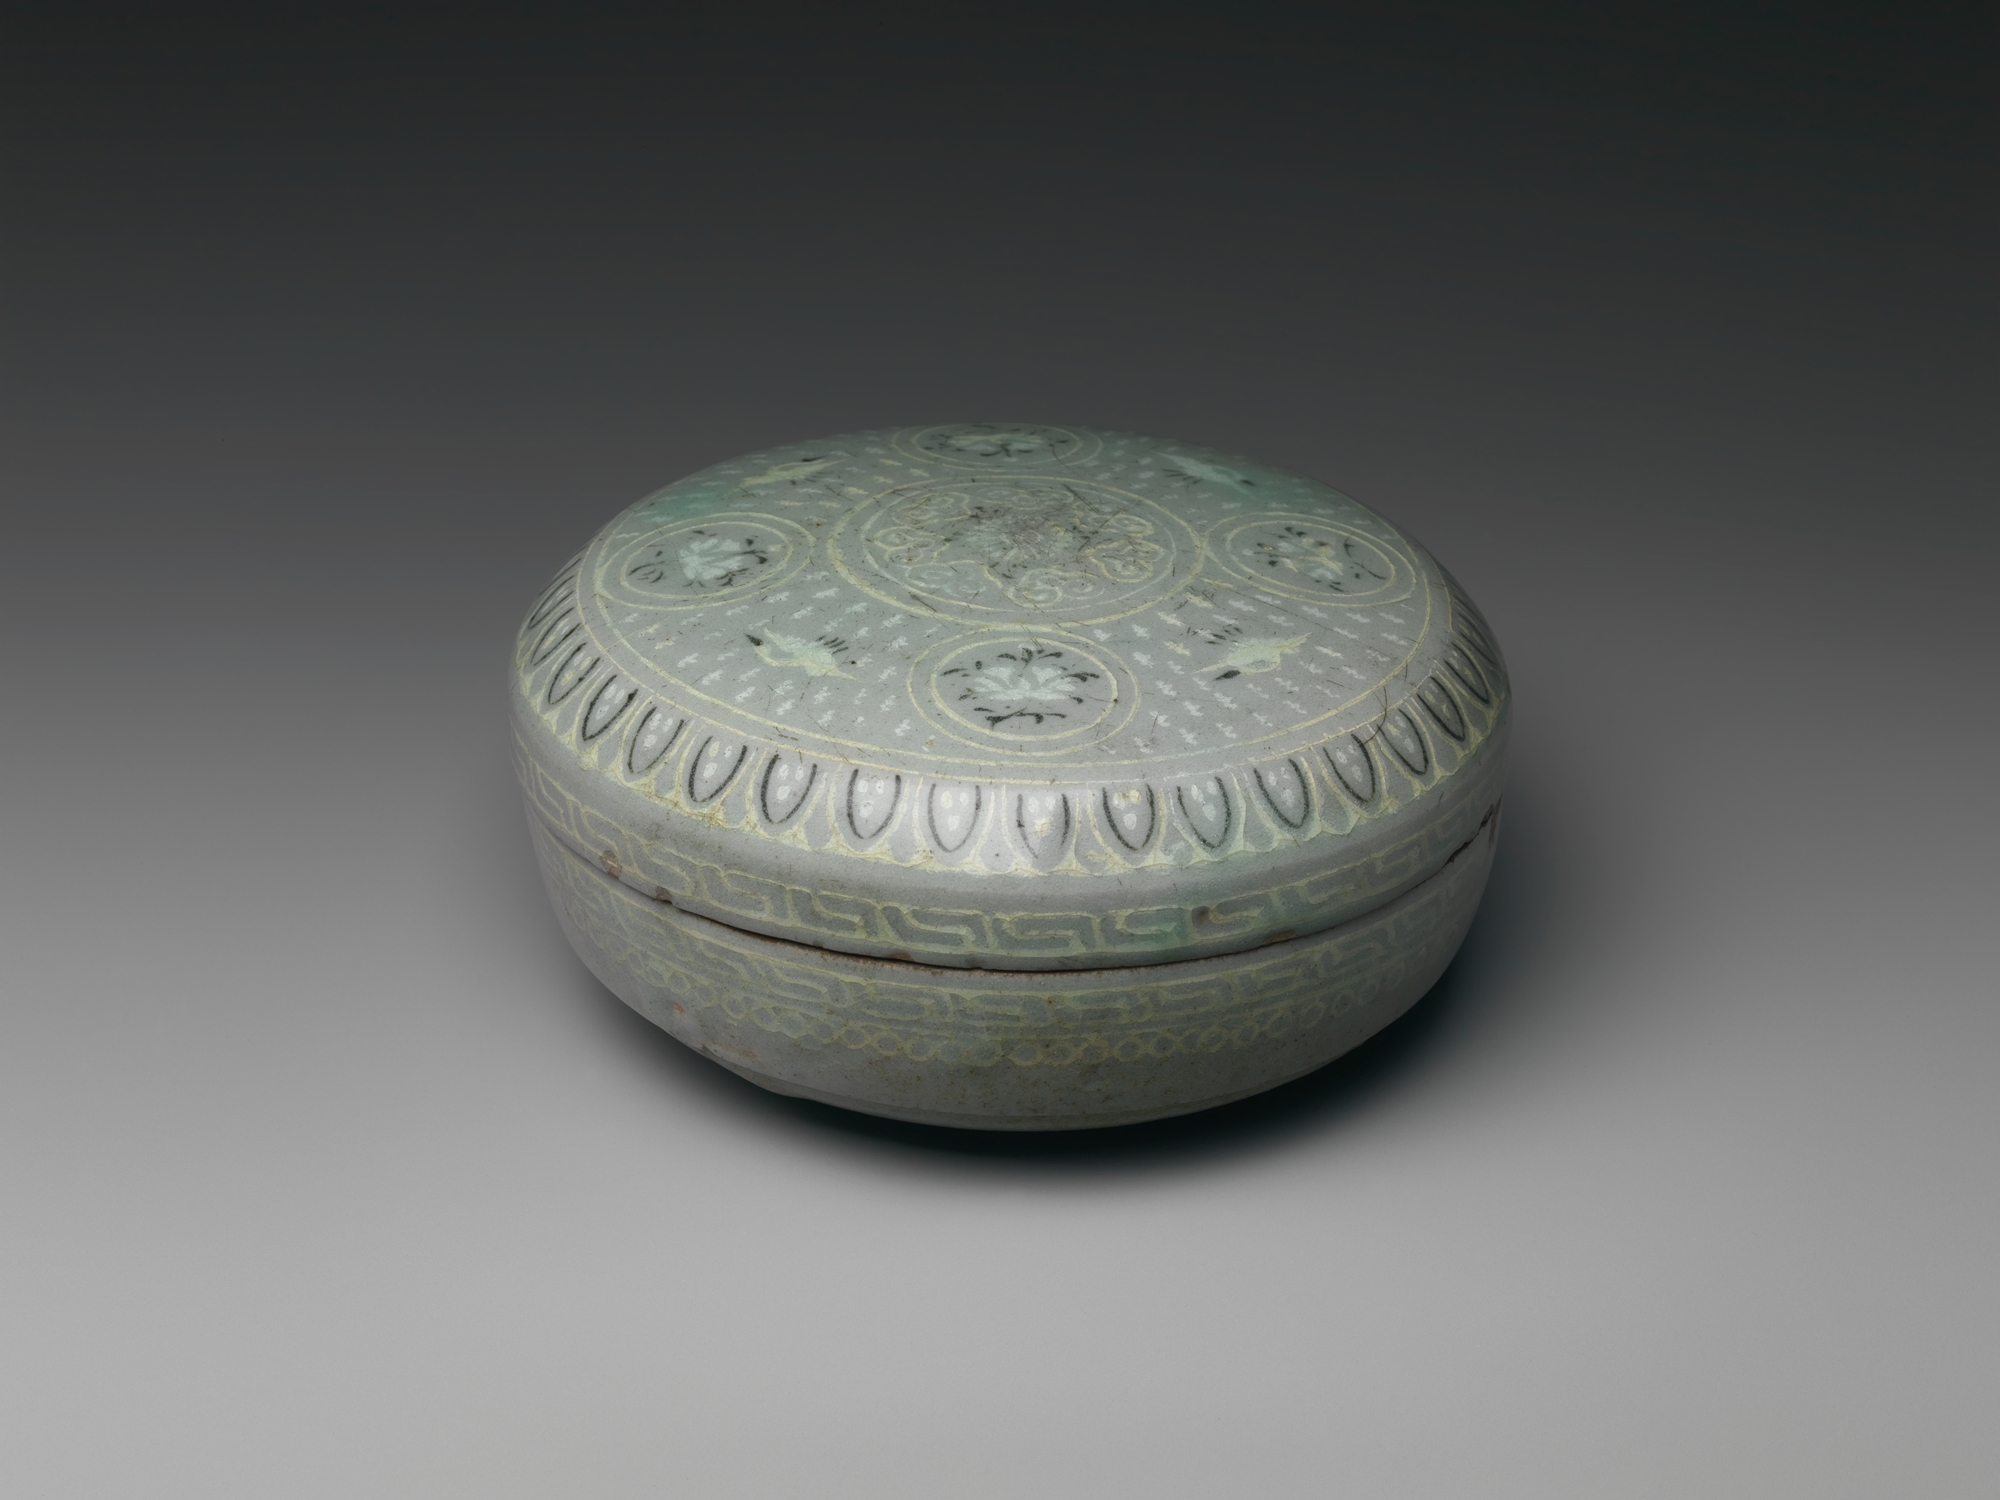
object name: box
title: Box from set of five decorated with cranes and clouds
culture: korean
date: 1201-1400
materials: ceramic glaze, glaze, stoneware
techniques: inlay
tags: cranes